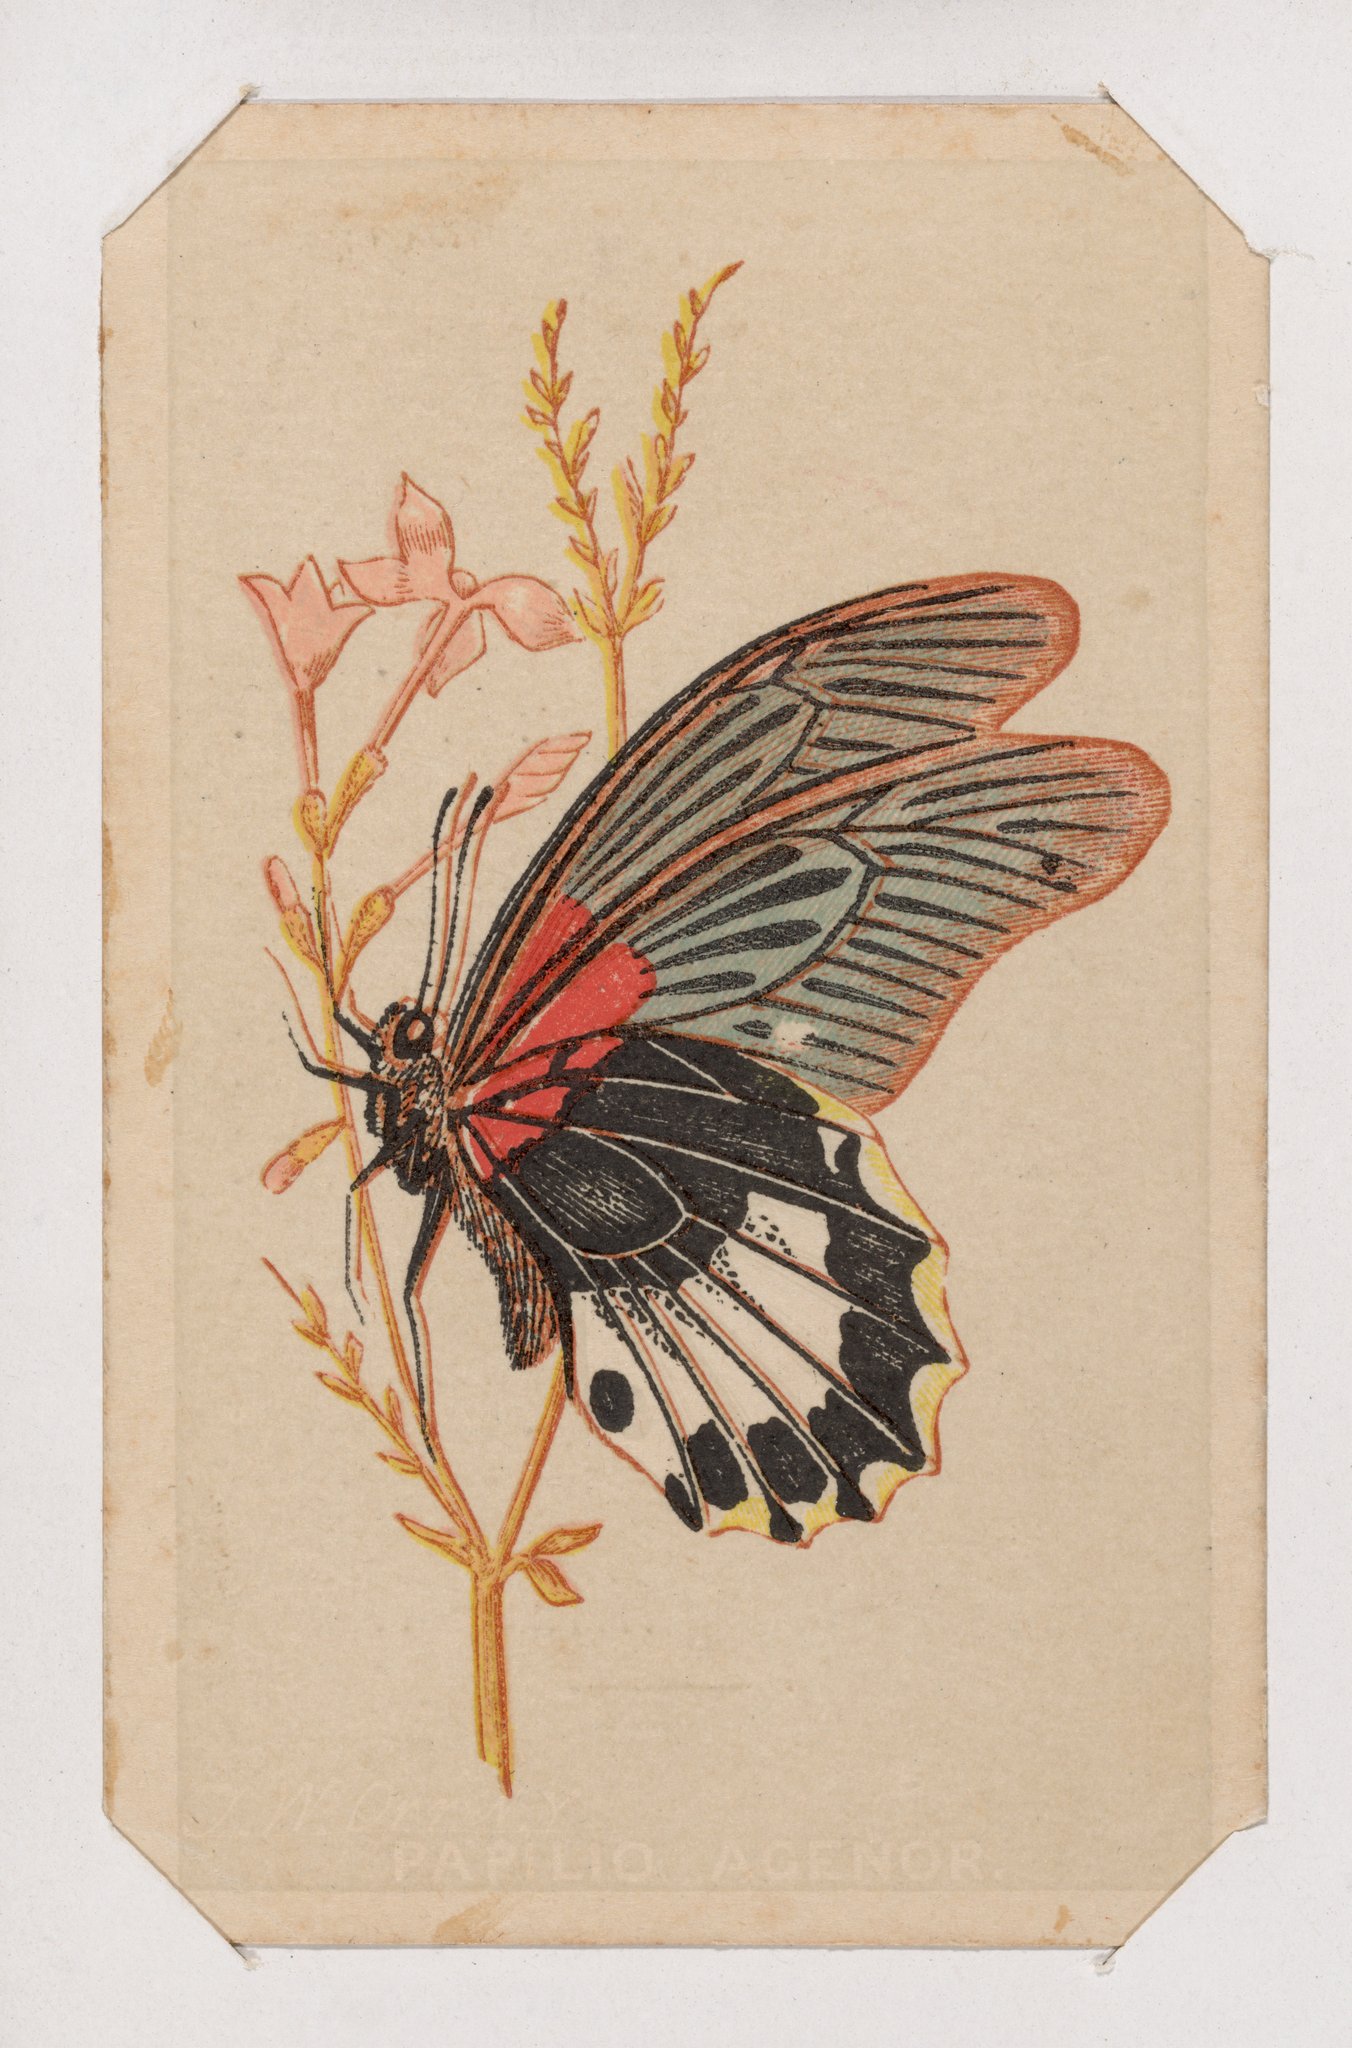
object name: album card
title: Butterfly card from the Butterflies and Moths of America series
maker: louis prang & co.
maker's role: publisher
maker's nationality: american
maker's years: 1800-1950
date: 1862-1869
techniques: lithograph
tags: butterflies